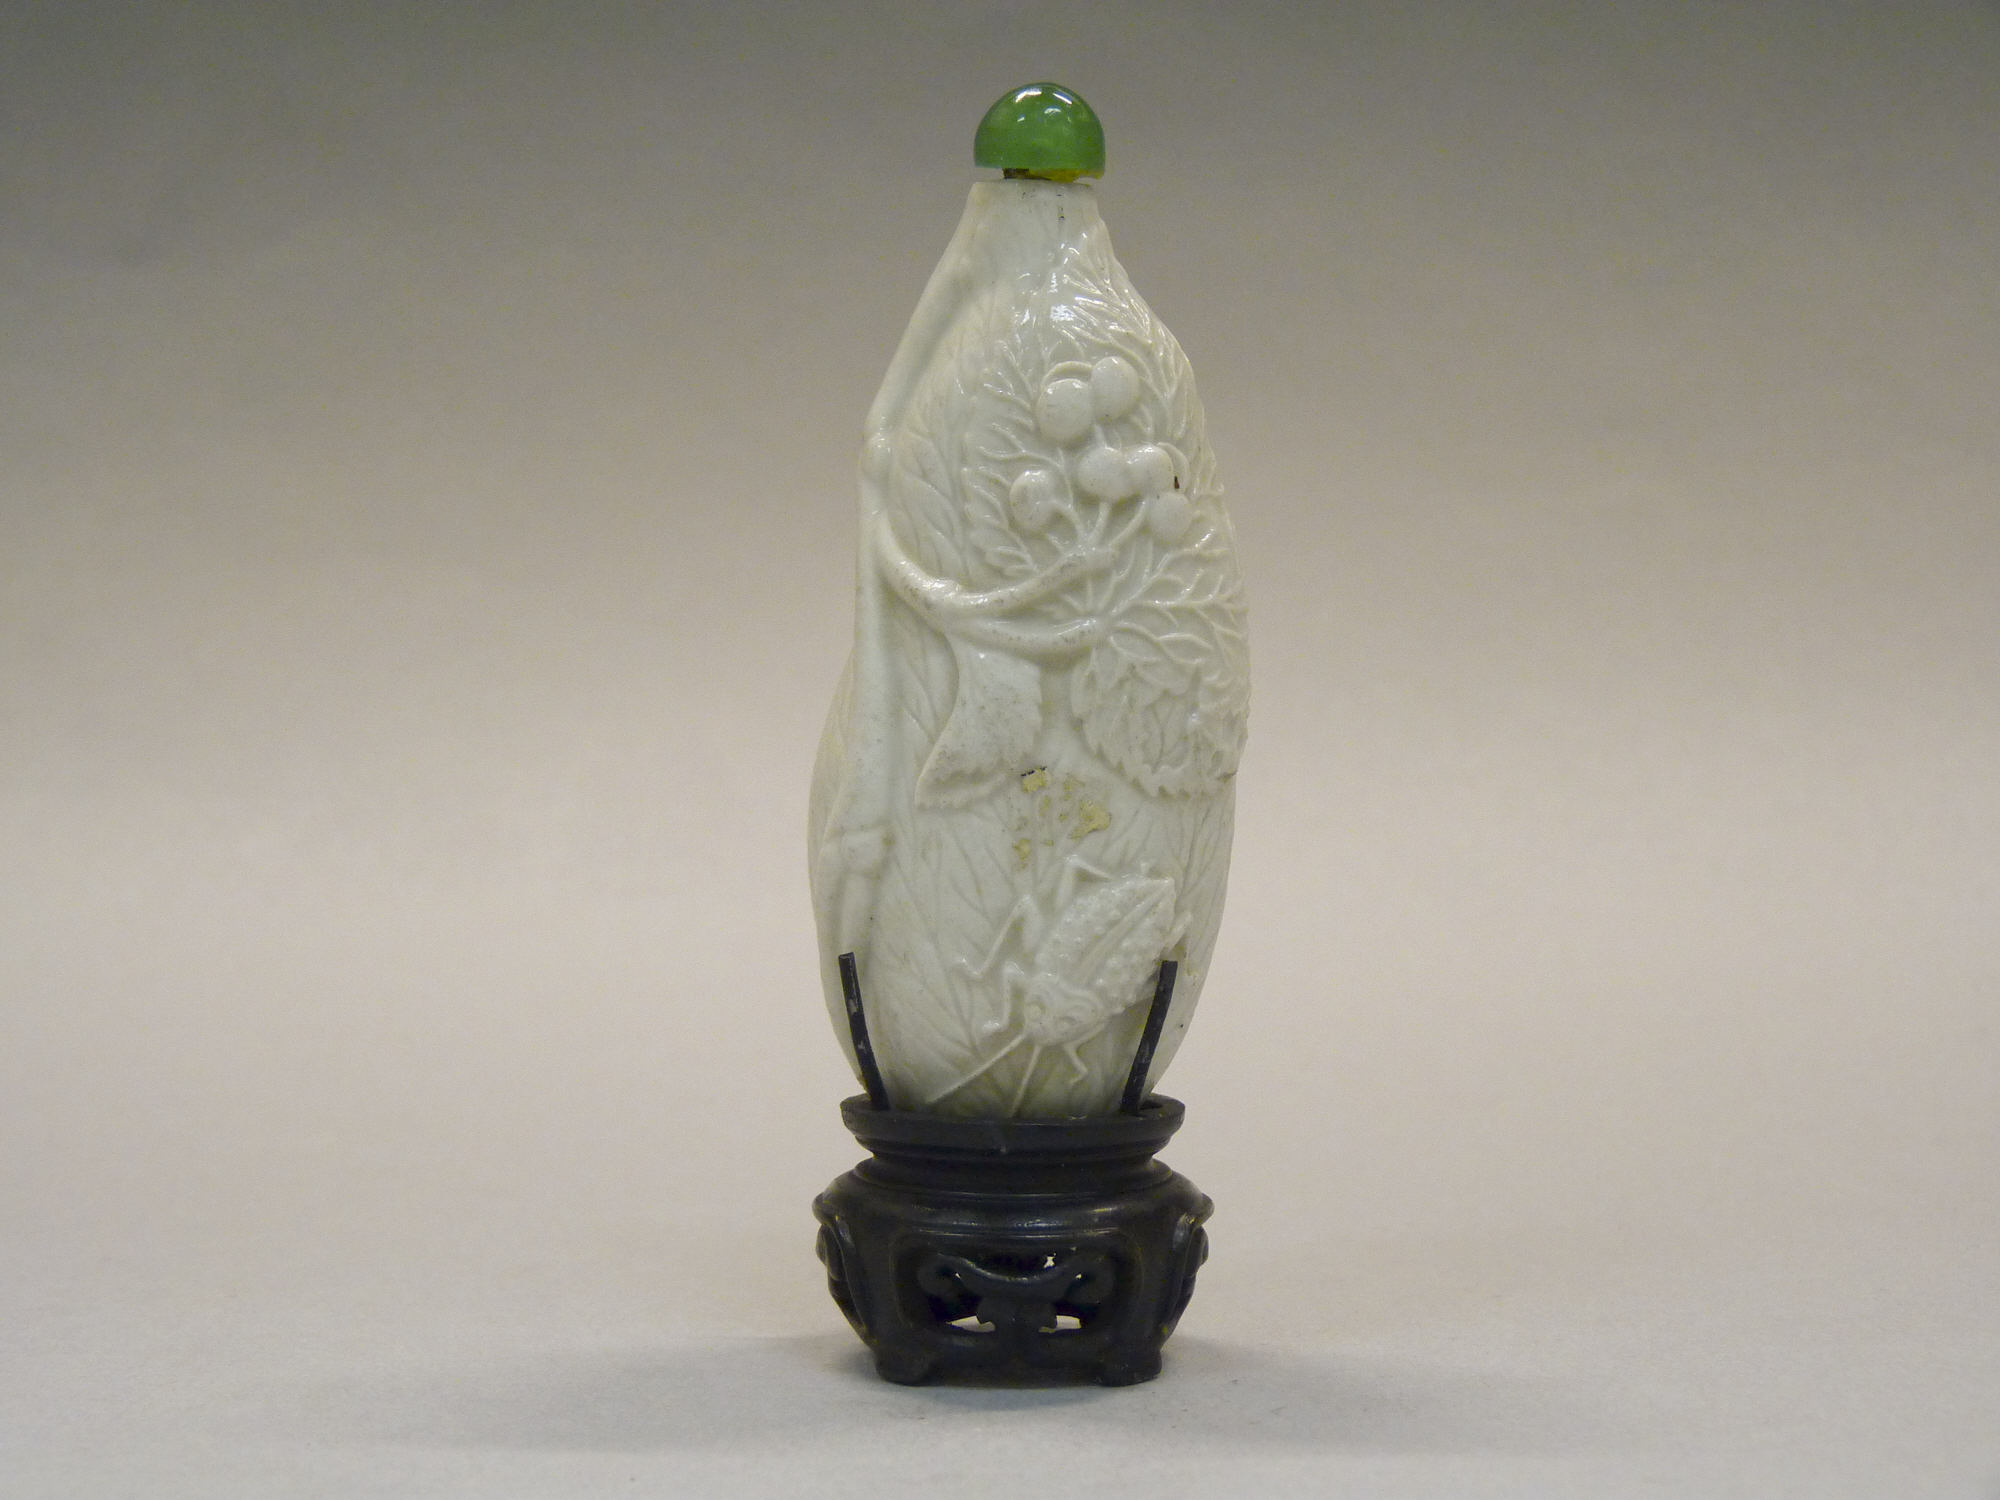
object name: snuff bottle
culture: chinese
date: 1736-1795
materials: glass, porcelain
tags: insects,leaves